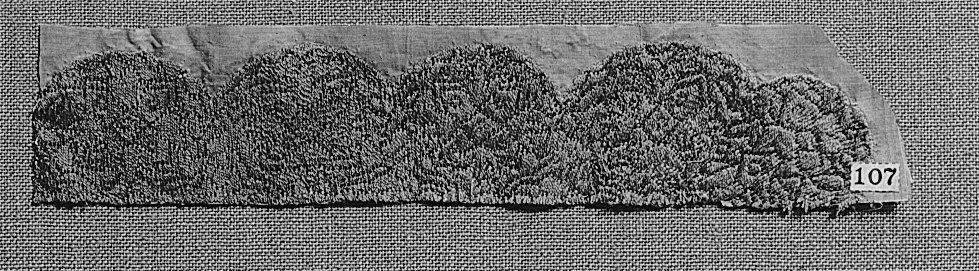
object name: fragment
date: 1601-1700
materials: silk, thread